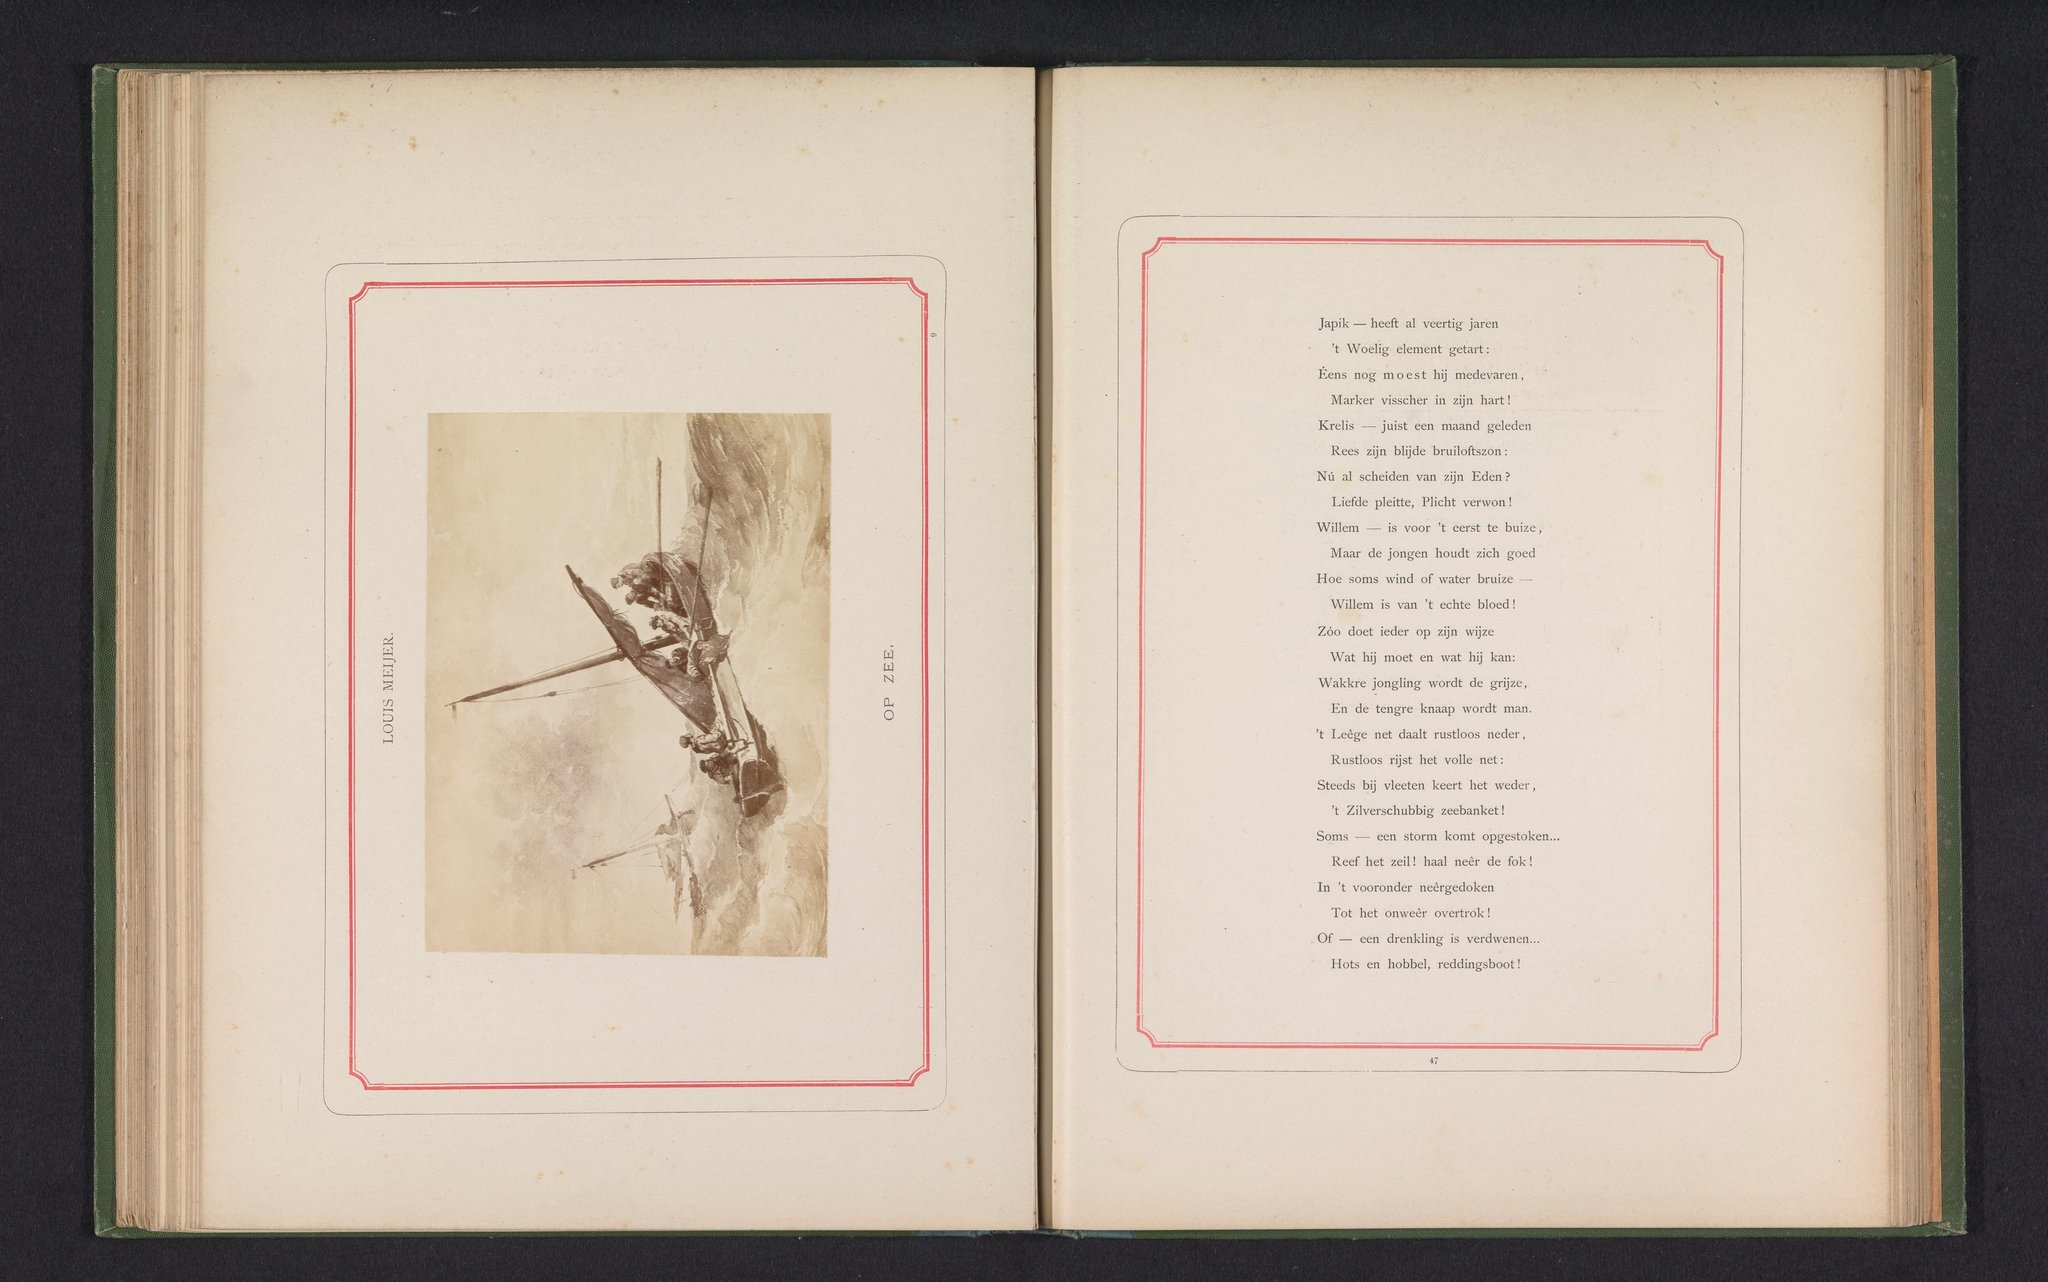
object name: page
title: Op zee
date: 1868-1878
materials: photographic support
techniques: albumen print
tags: rowing-boat, canoe, etc., sea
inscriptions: number: ‘9’